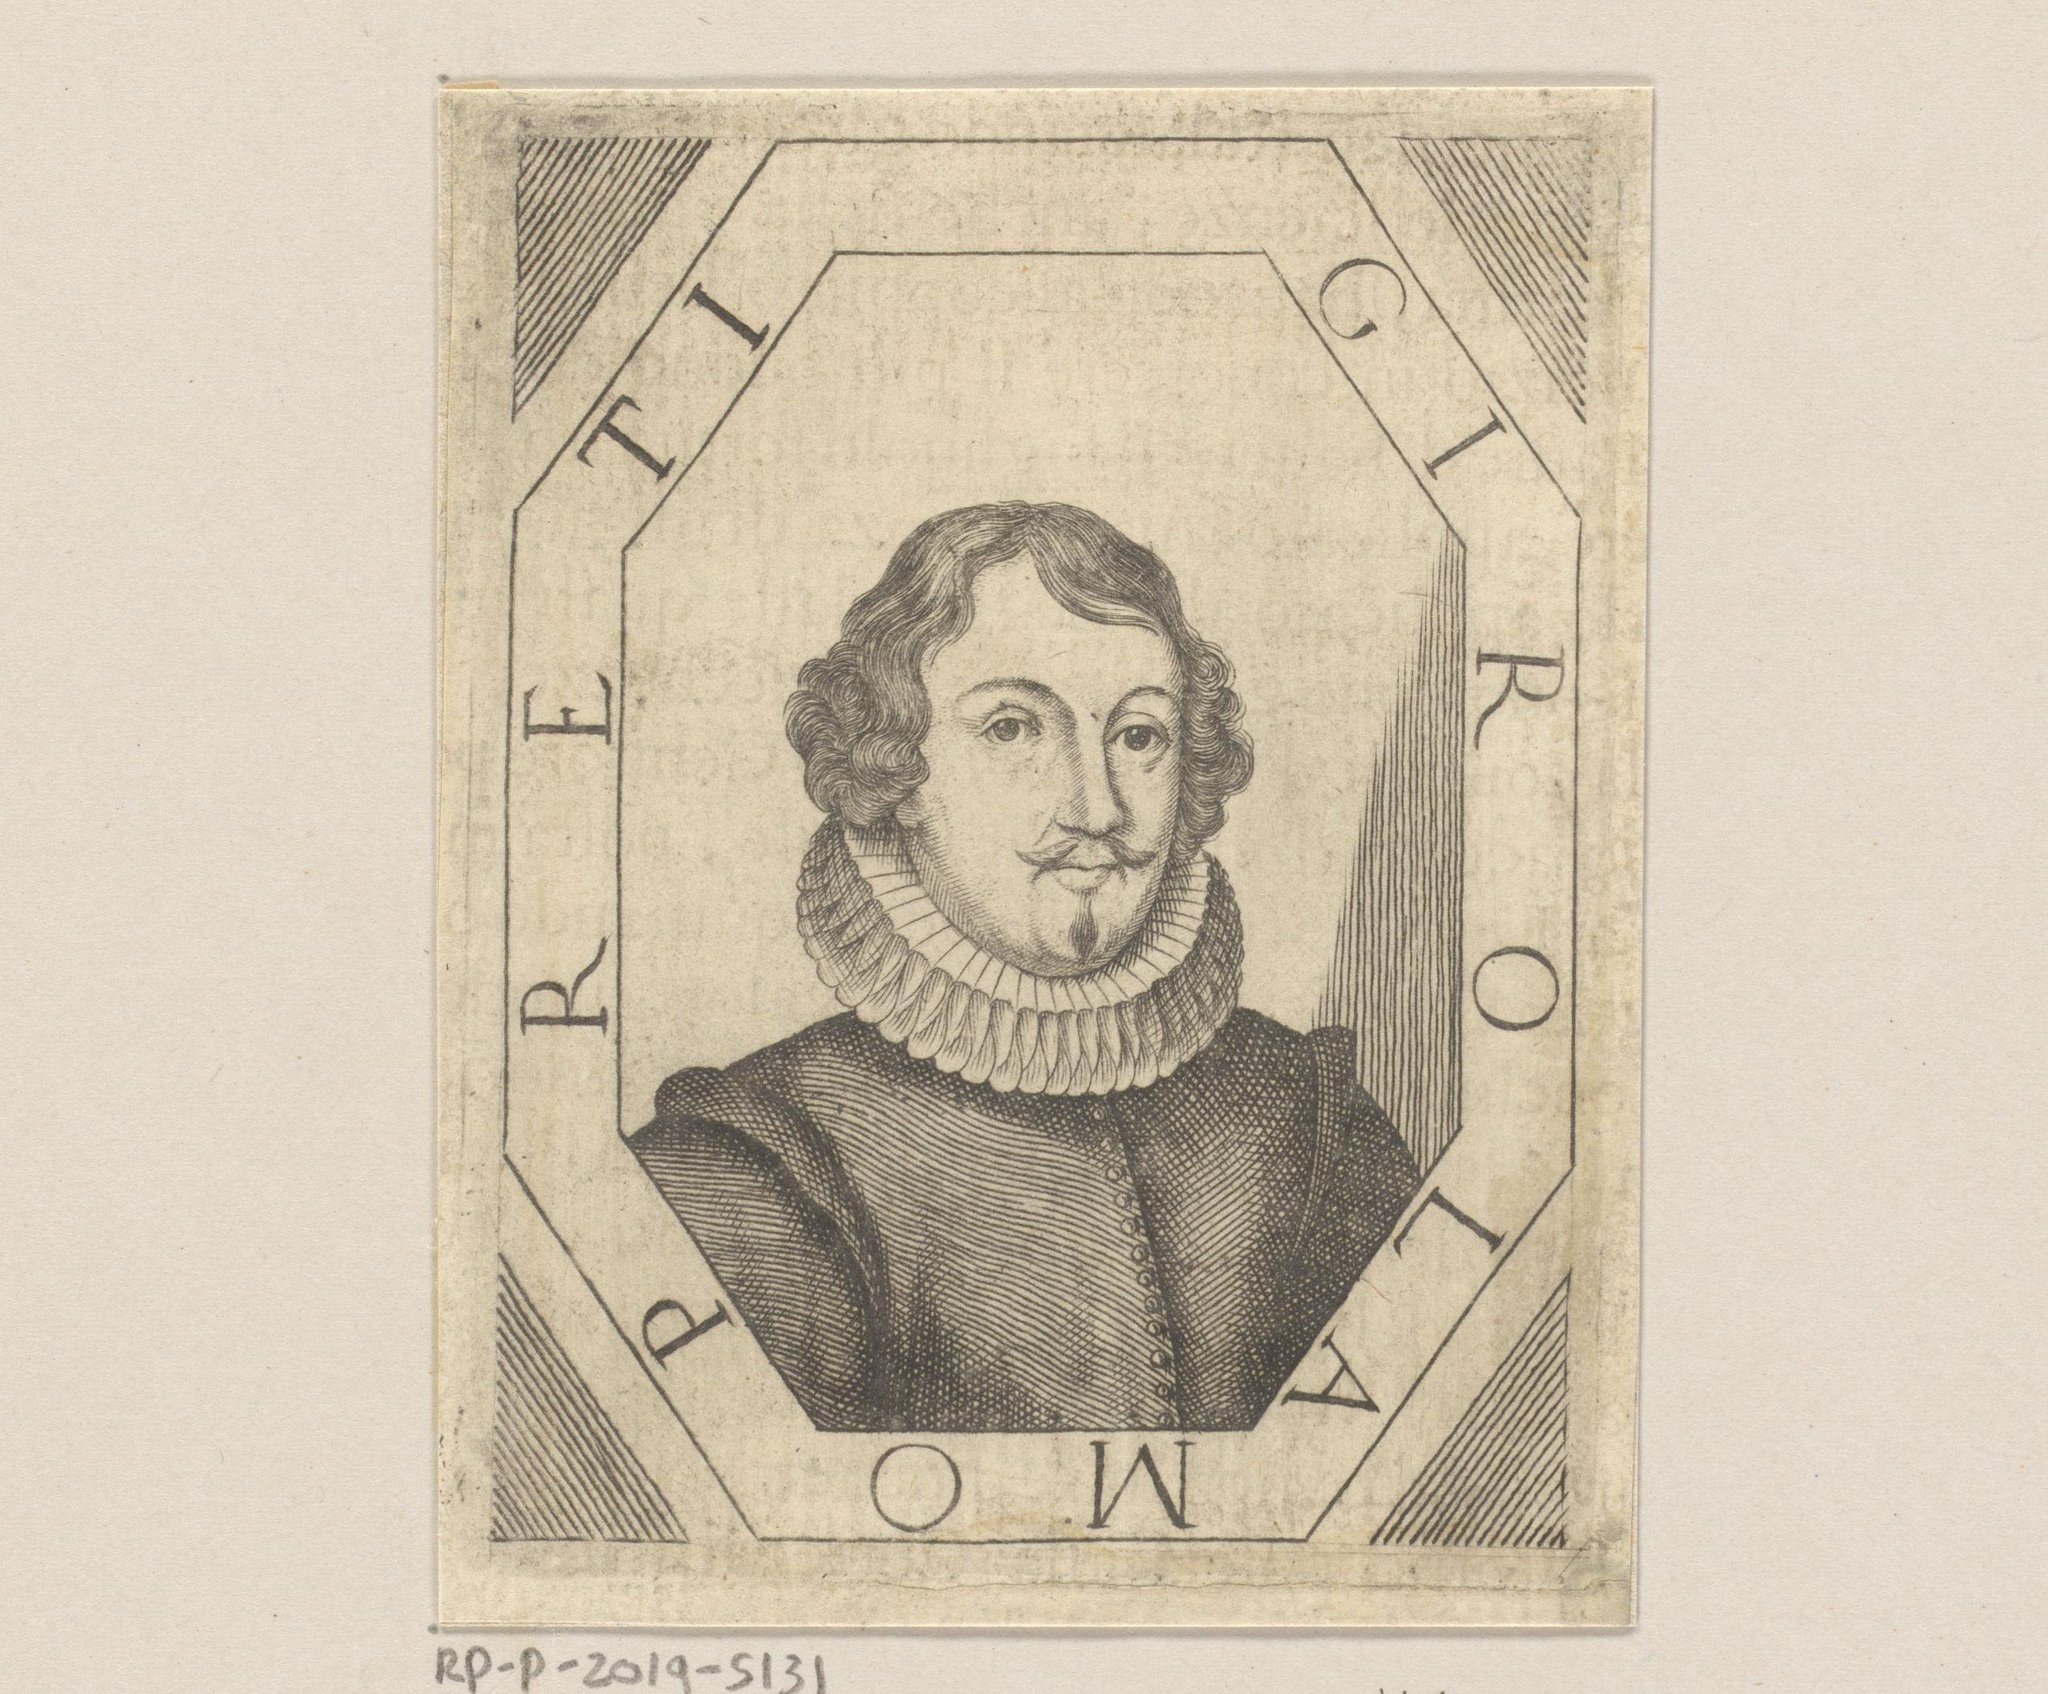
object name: print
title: Portret van dichter Girolamo Preti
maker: Anonymous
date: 1666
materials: paper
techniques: engraving, letterpress printing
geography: venice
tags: historical persons, portrait of a writer, writer, poet, author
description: Prent uit: Crasso, Lorenzo. Elogii degli huomini letterati scritti. Venetië: Combi & la Noù, 1666, dl. 2, p. 140.